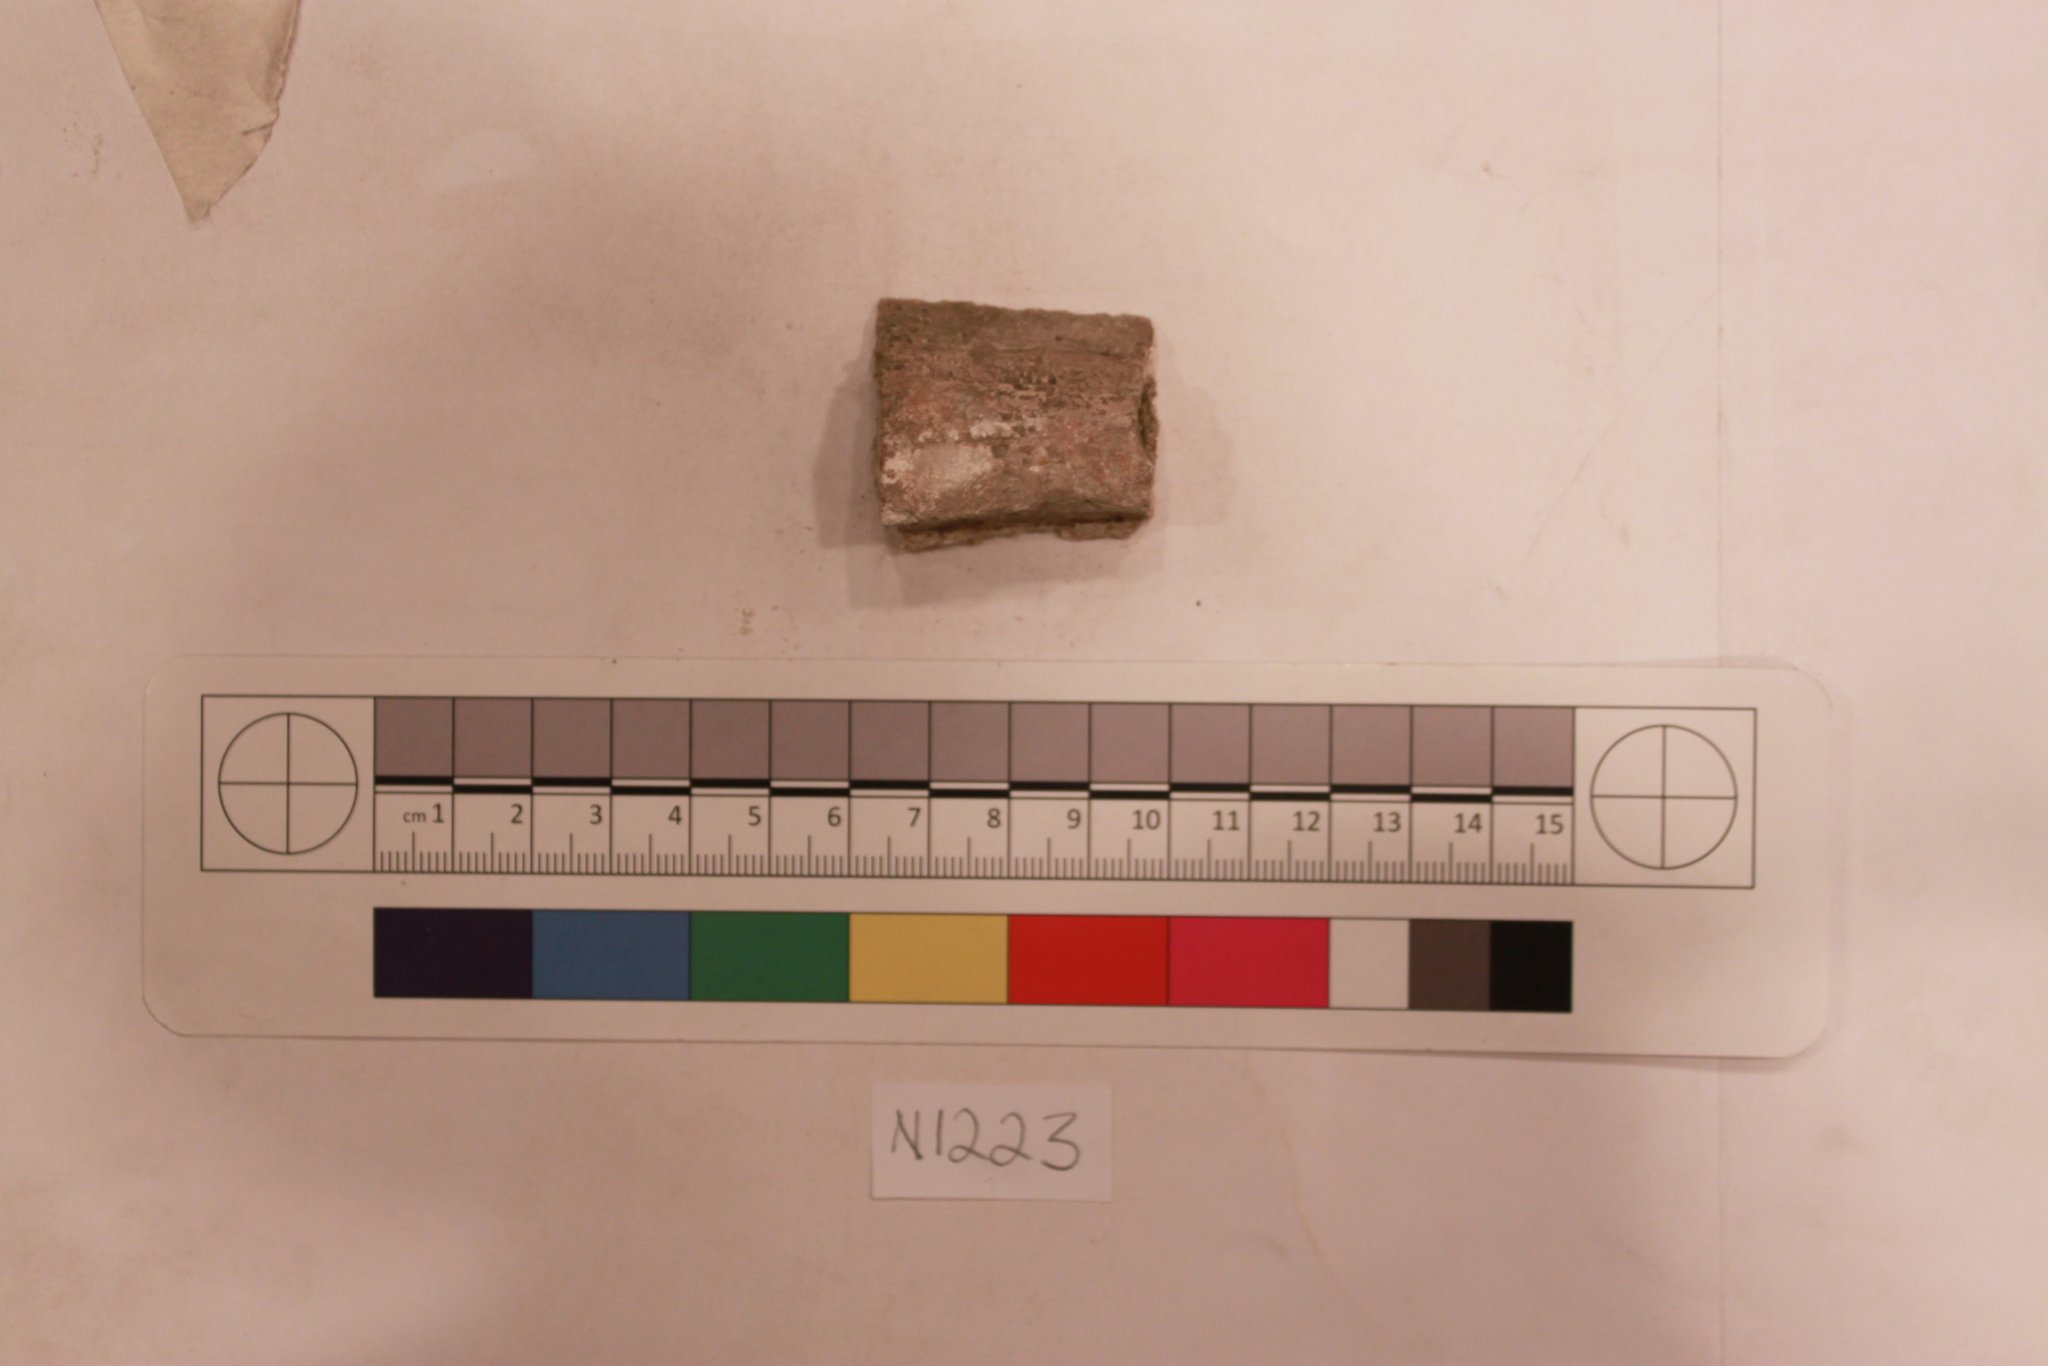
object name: fragment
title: Stucco Fragment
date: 701-1200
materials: plaster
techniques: carving, painting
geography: iran